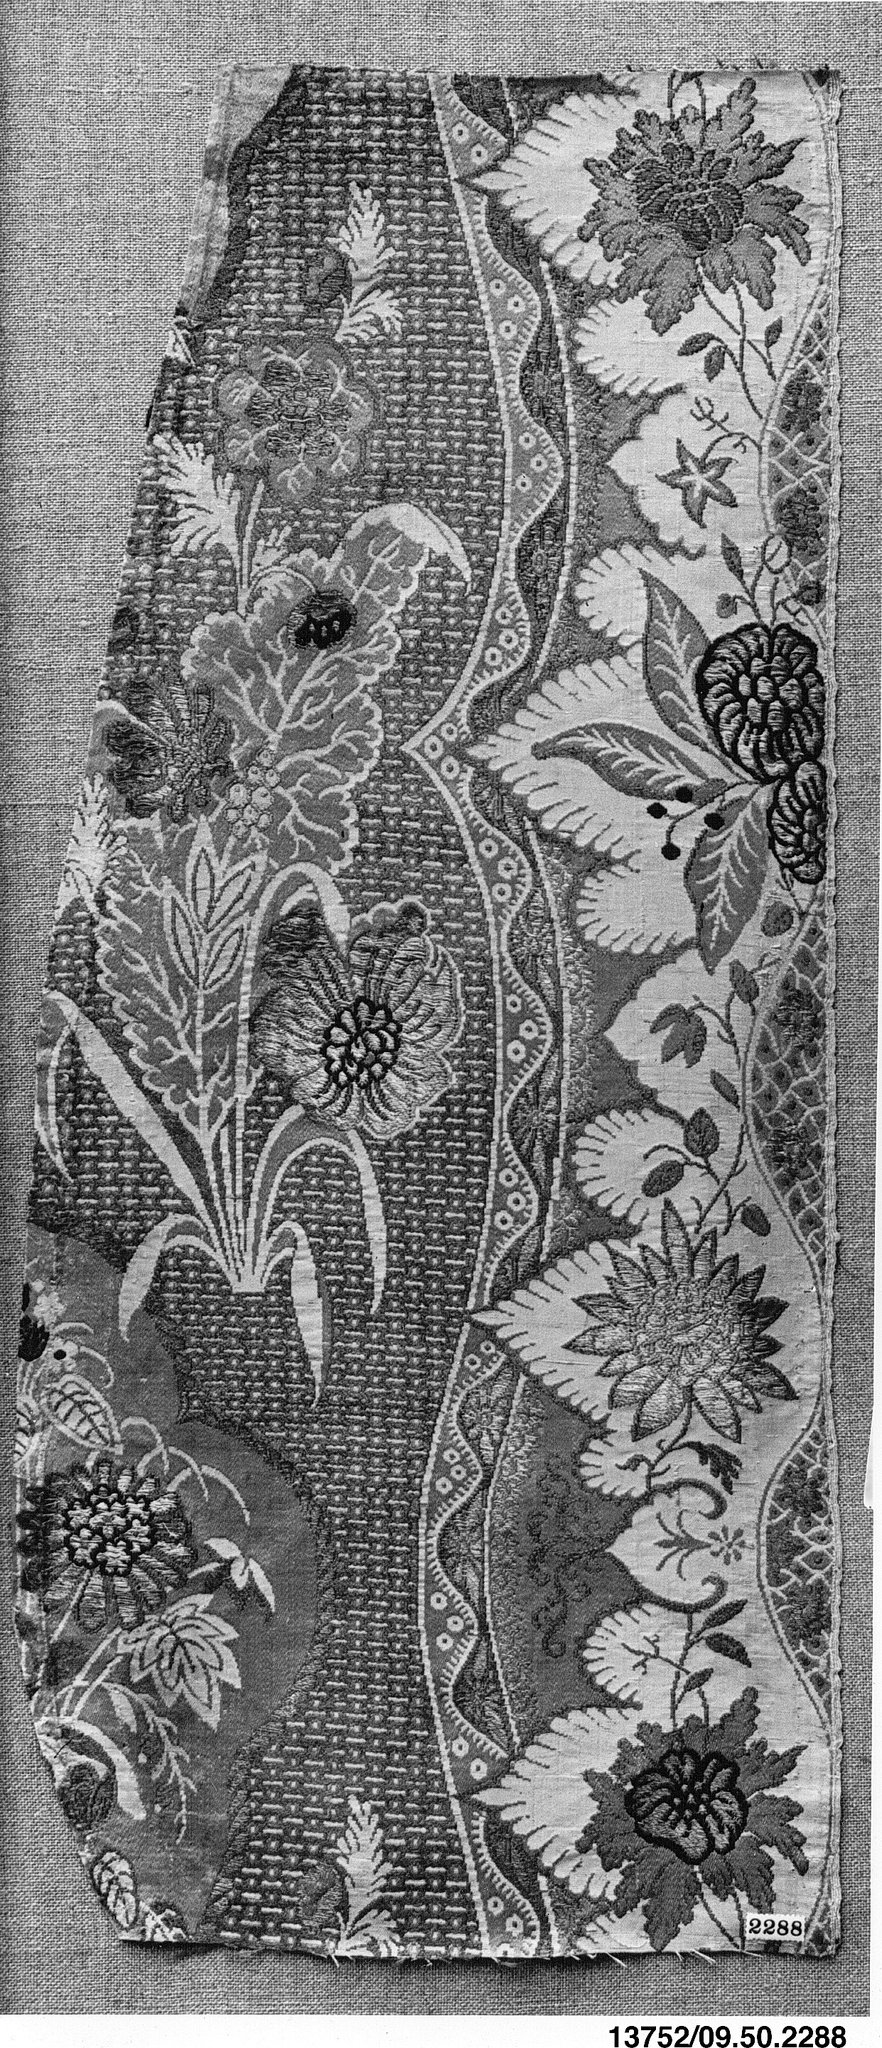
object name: piece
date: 1720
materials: metal thread, silk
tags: flowers,leaves